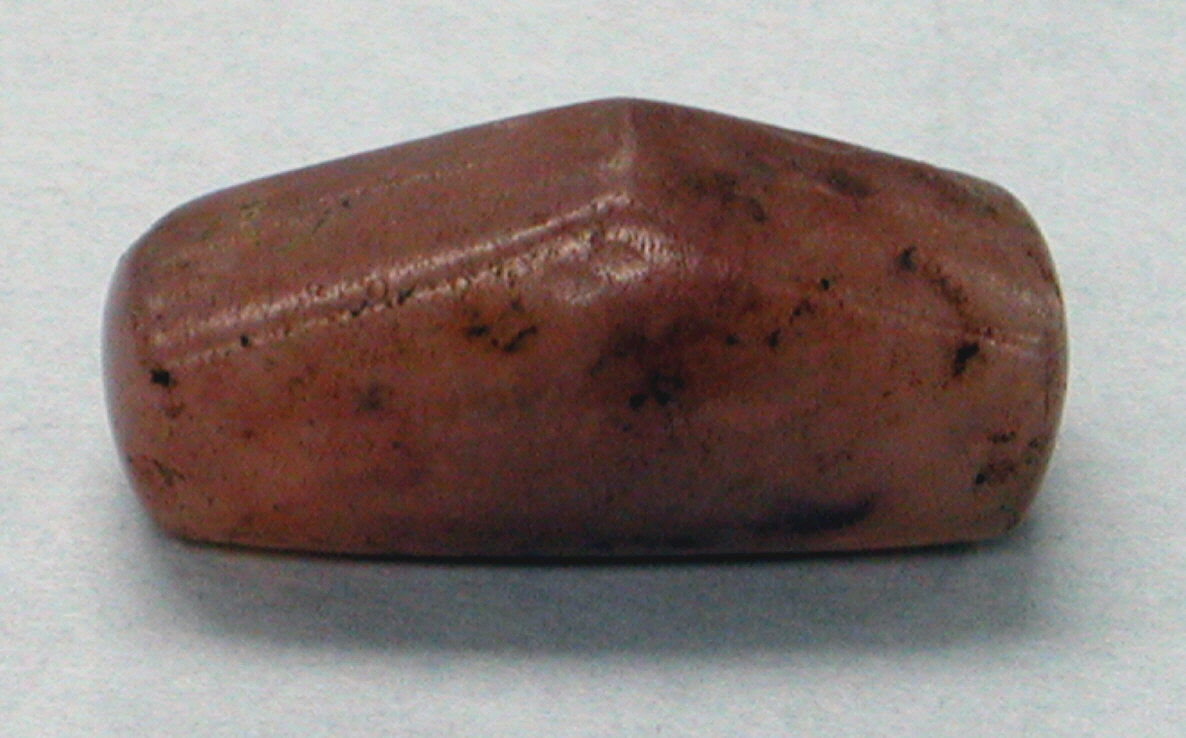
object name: ritual stone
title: Stone Pulidor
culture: mexican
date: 1501-1600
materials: stone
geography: mexico